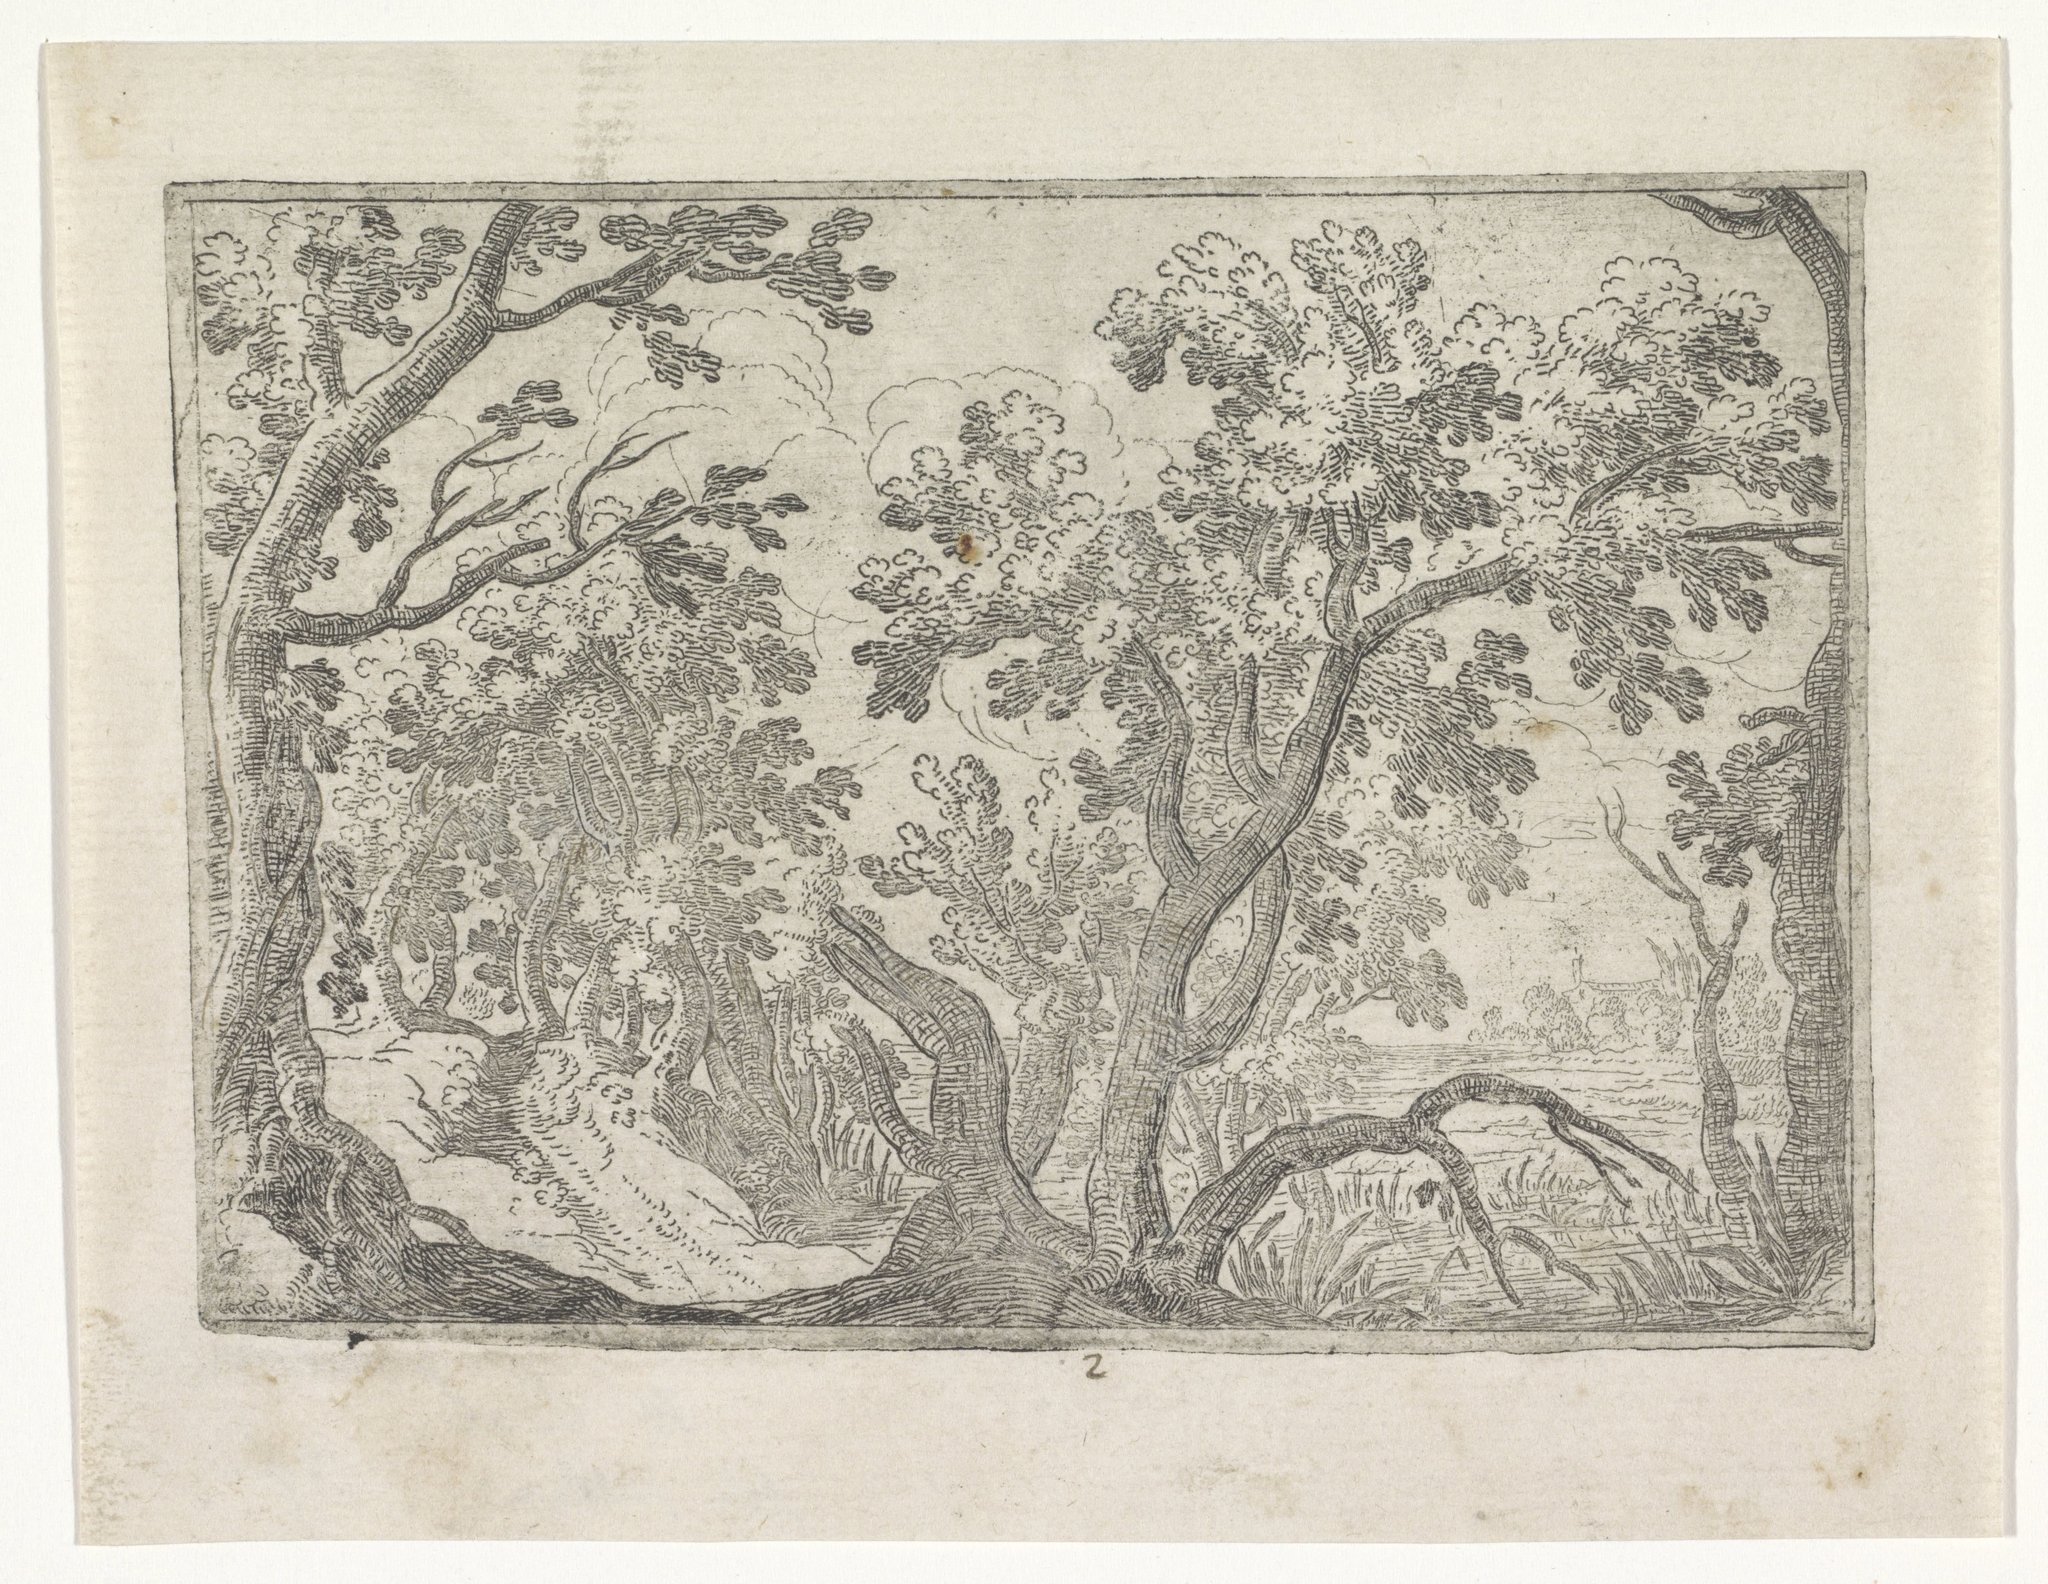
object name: print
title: Landschap met bos en water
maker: Anonymous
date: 1600-1700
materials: paper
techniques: etching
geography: netherlands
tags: landscapes in the temperate zone